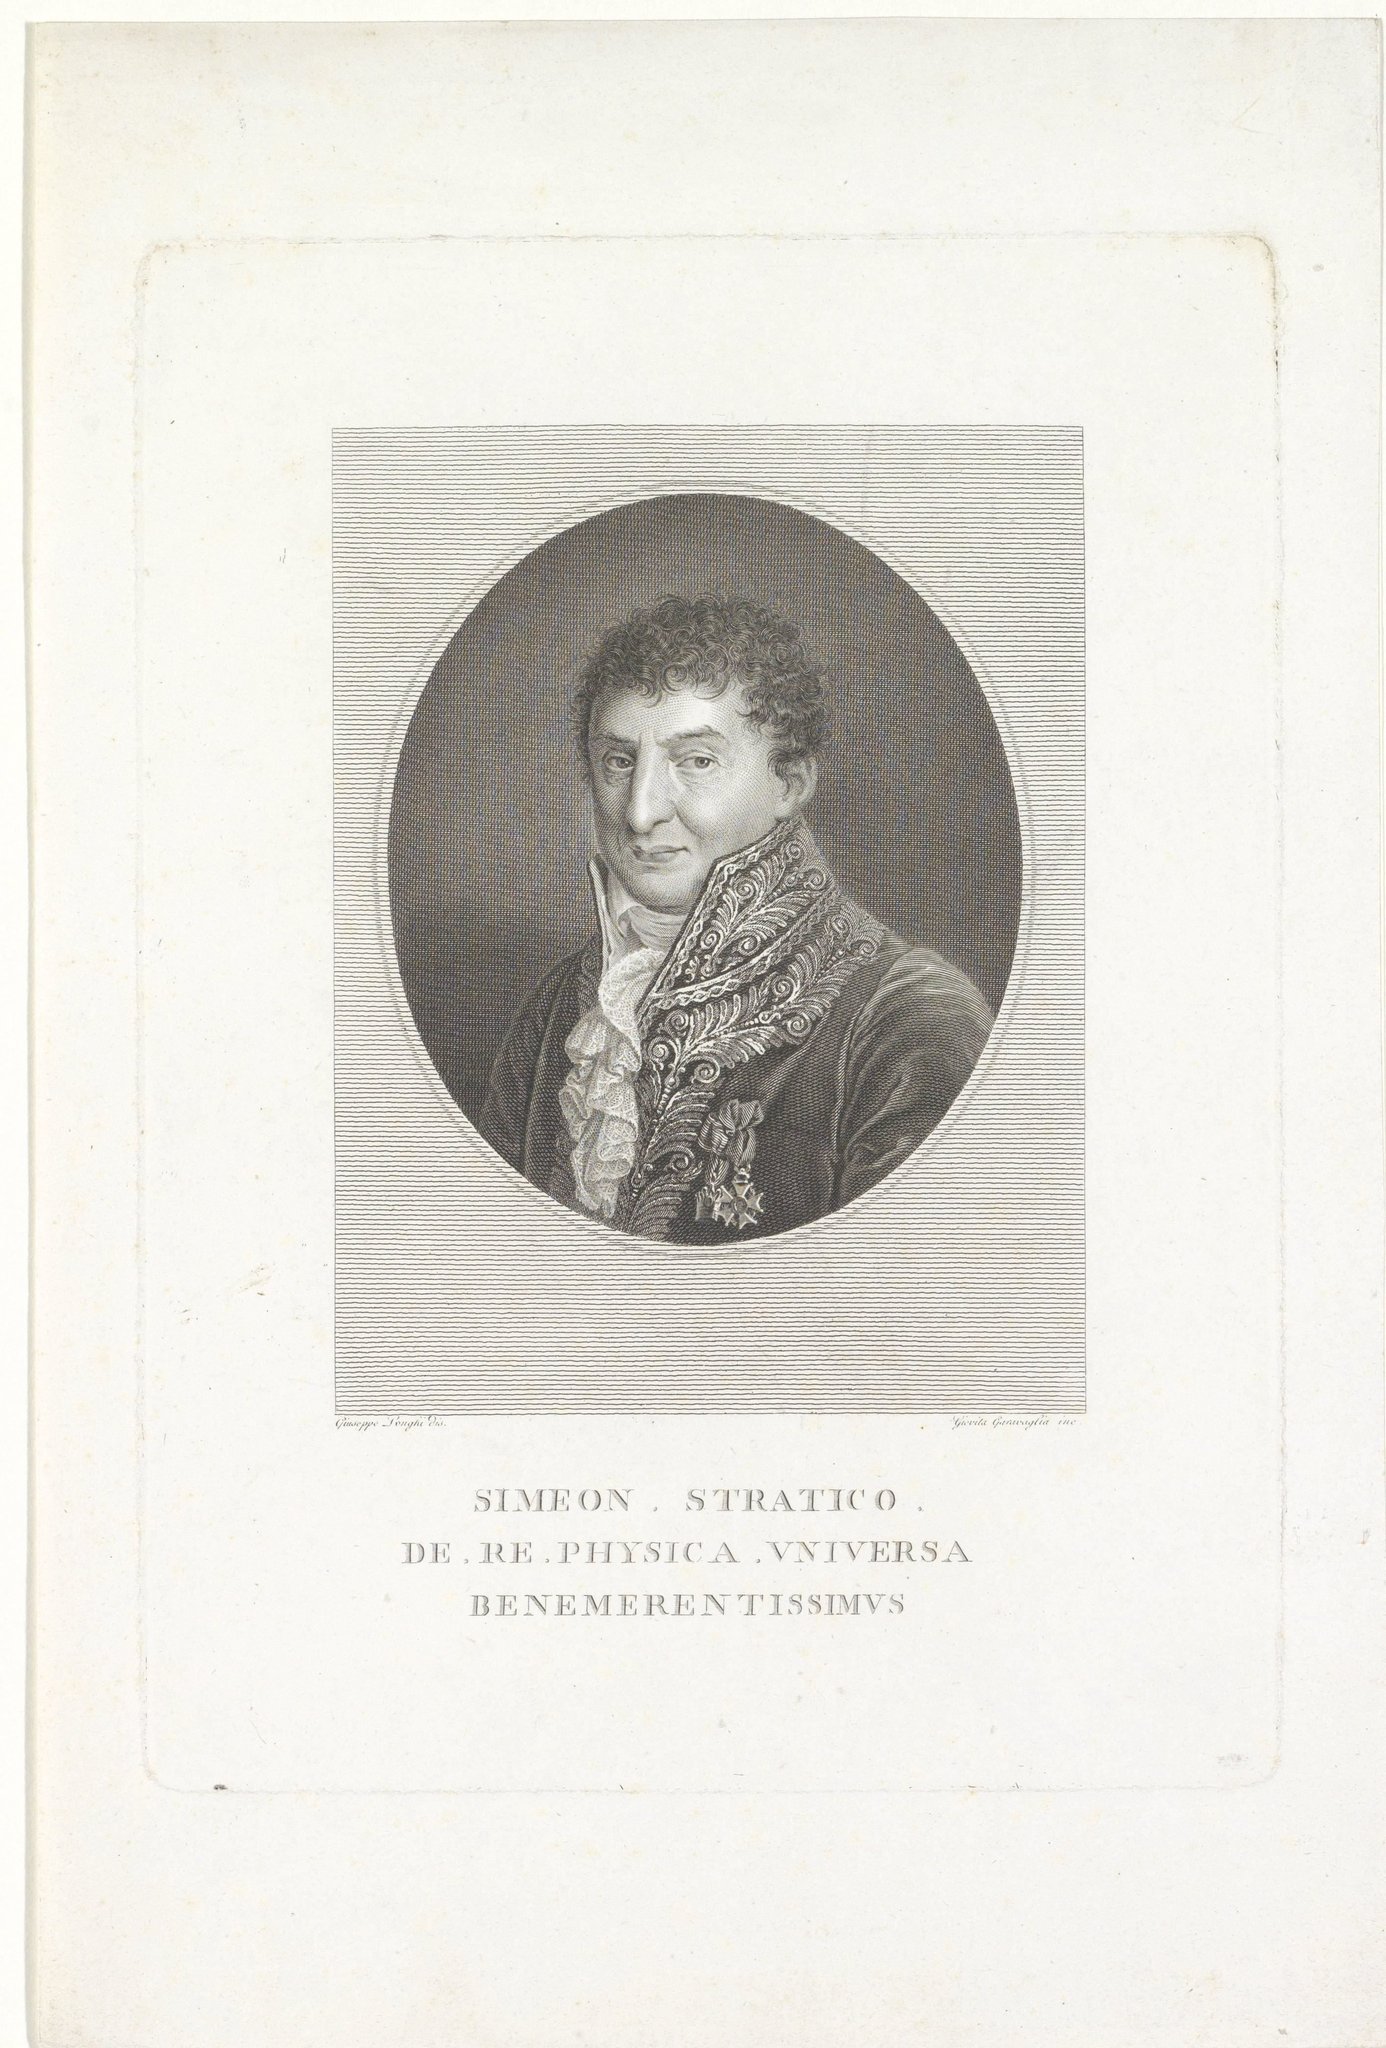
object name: print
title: Portretten van beroemde Italianen in ovalen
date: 1800-1835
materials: paper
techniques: engraving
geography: italy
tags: physicist, historical persons, science and technology (+ portrait of scholar, scientist)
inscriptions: collector's mark: Lugt 2228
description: Deze prent maakt deel uit van een reeks portretprenten van onbekende omvang. De reeks is in meerdere staten uitgegeven. De eerste staat met enkel het portret in ovaal. Een tweede staat met naam van de geportretteerde in holle letters onder de voorstelling. Een derde staat met de naam van de geportretteerde in gevulde letters onder de voorstelling. En een vierde staat met een rechthoekig kader rondom het ovale portret.